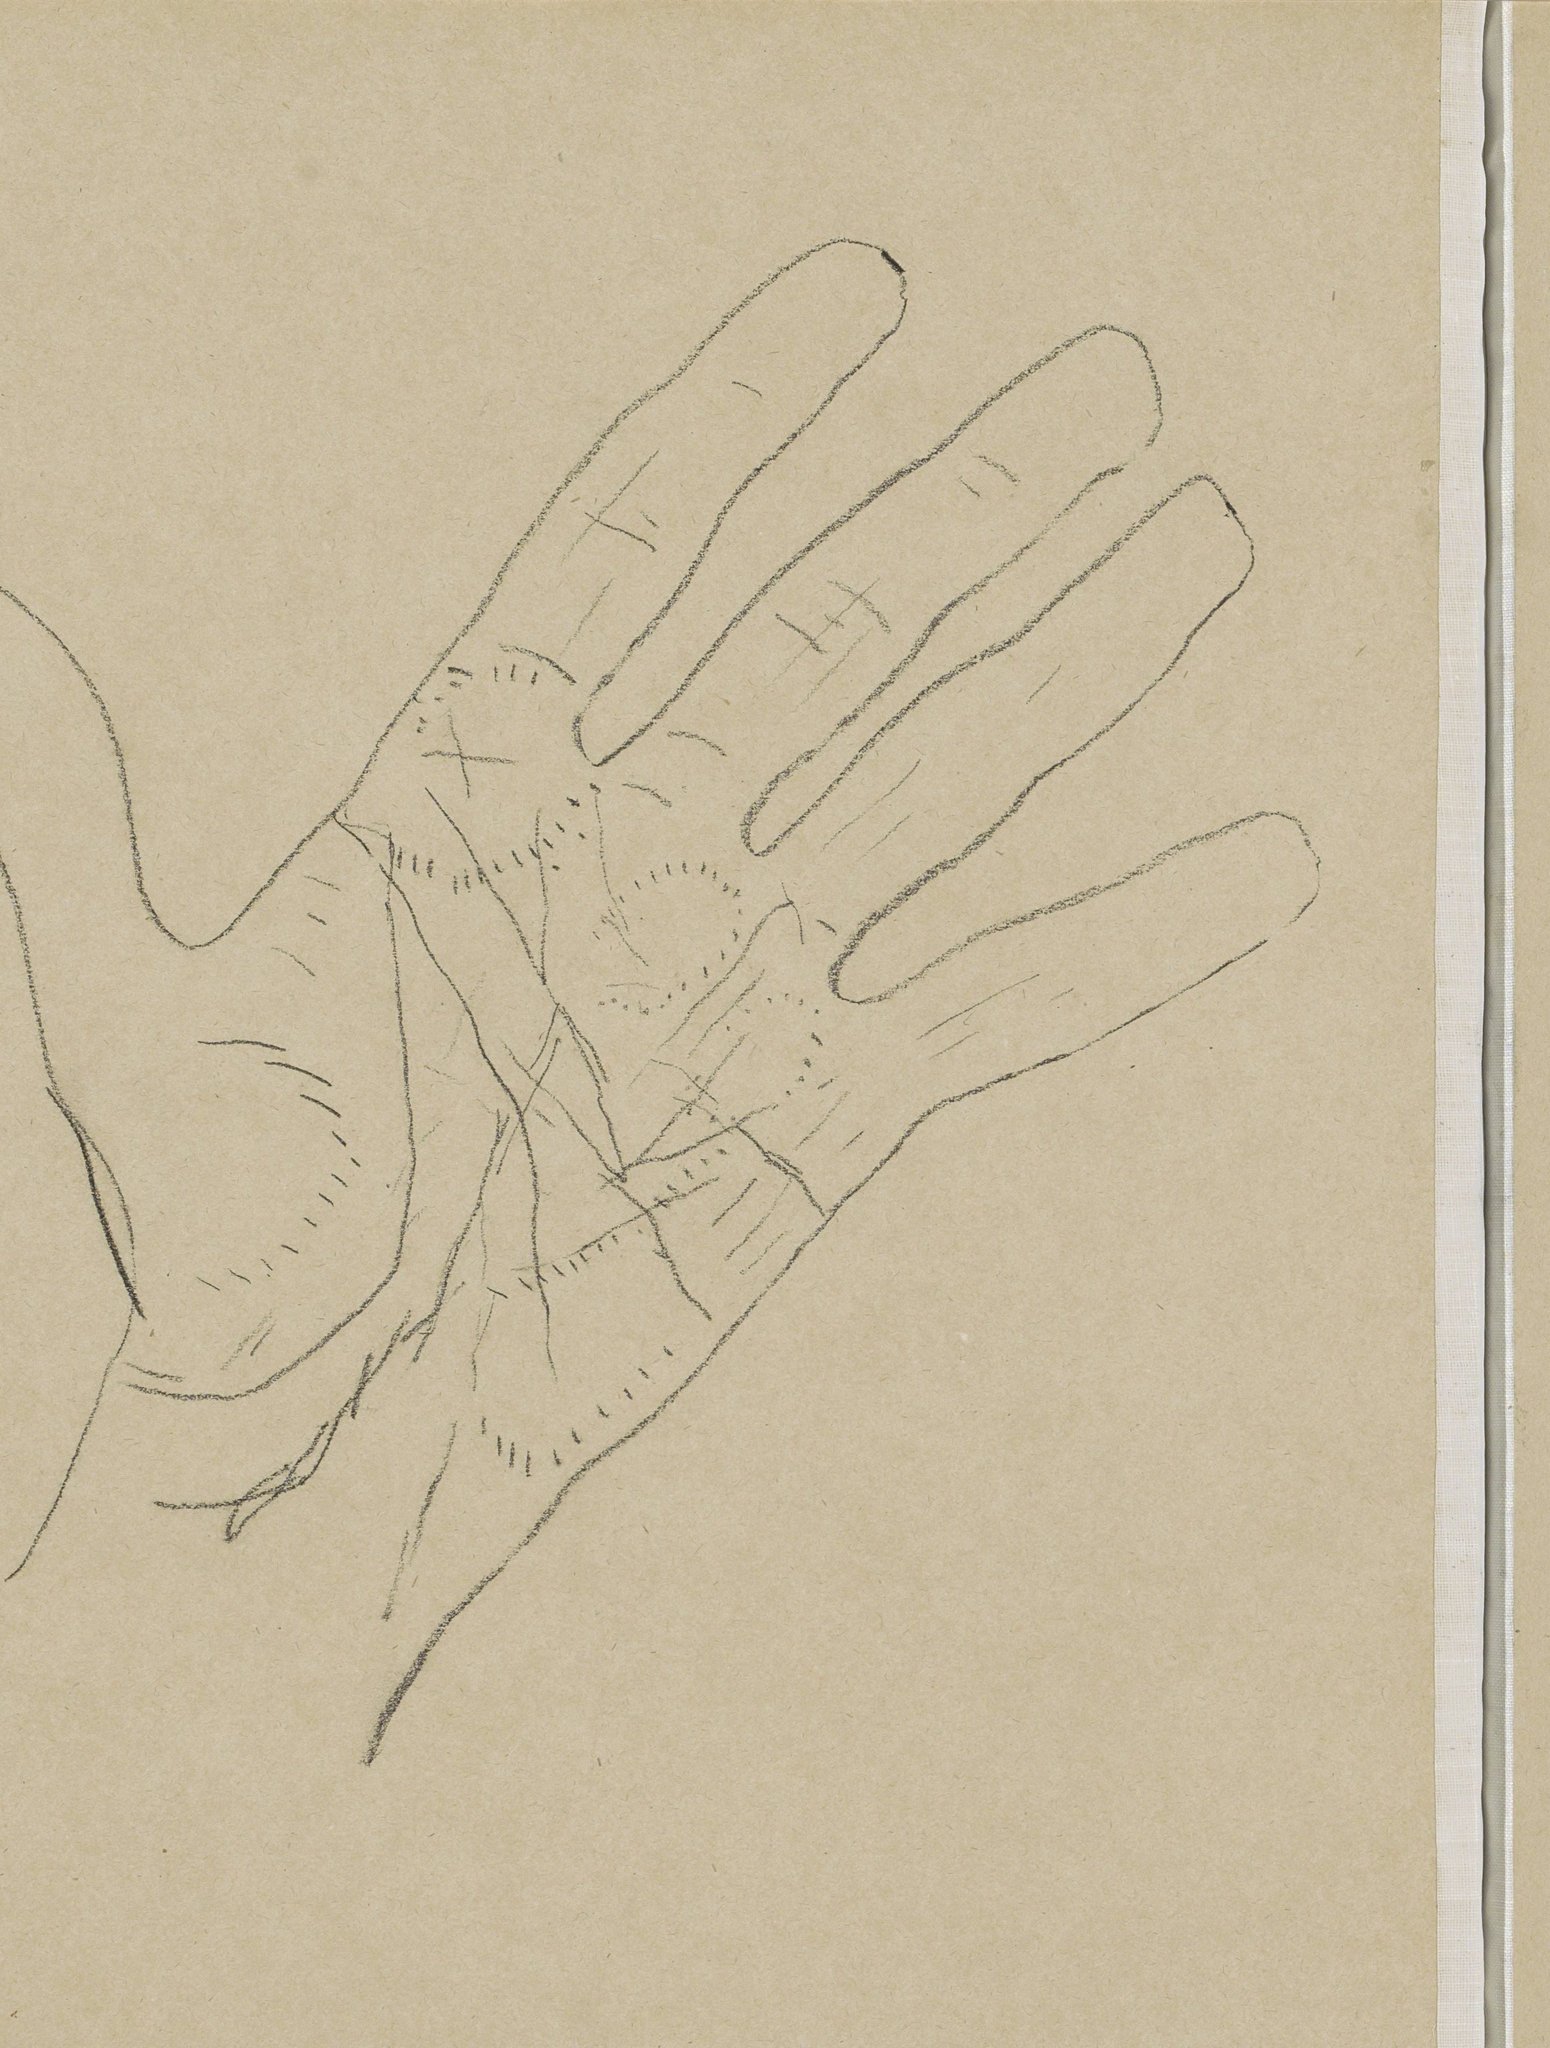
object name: sketchbook leaf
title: Hand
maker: willem witsen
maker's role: draughtsman, painter, print maker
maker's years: 1860-1923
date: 1874-1923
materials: chalk, paper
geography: ewijkshoeve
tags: hand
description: Pagina 32 uit een schetsboek met 72 bladen.